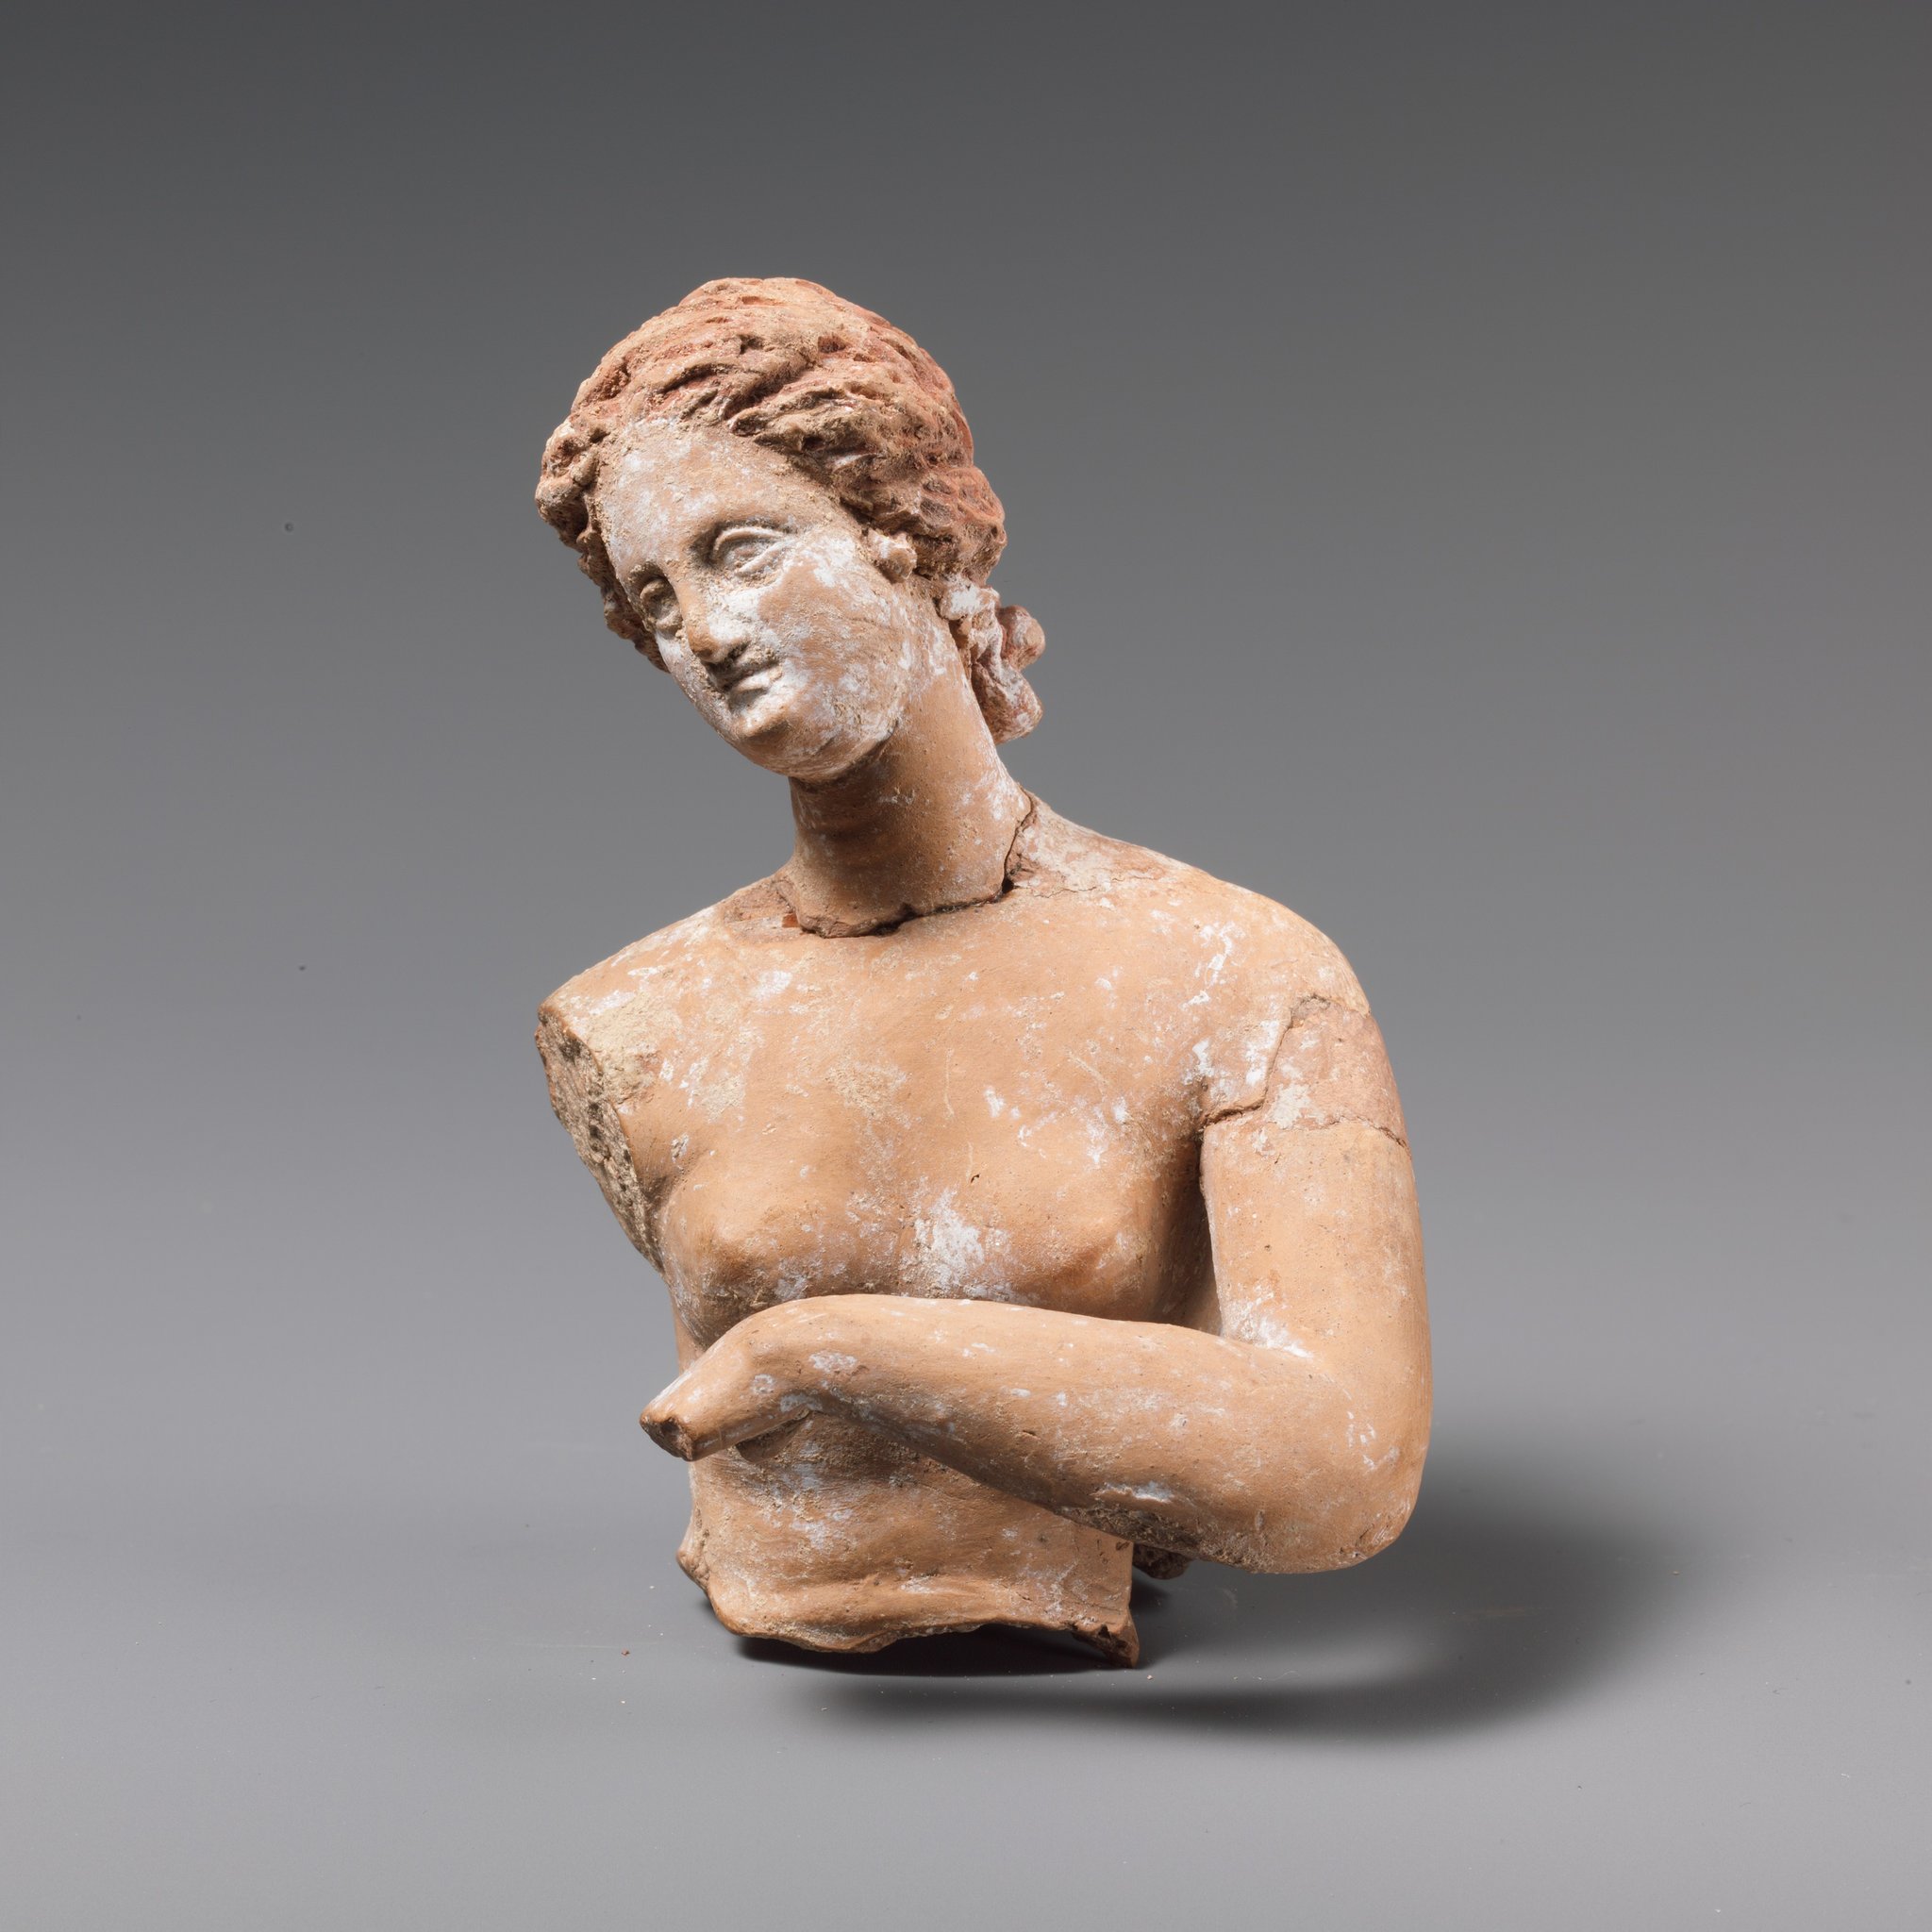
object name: statuette of a woman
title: Fragmentary terracotta statuette of a woman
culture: greek, attic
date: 300-201 BCE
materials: terracotta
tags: portraits,women